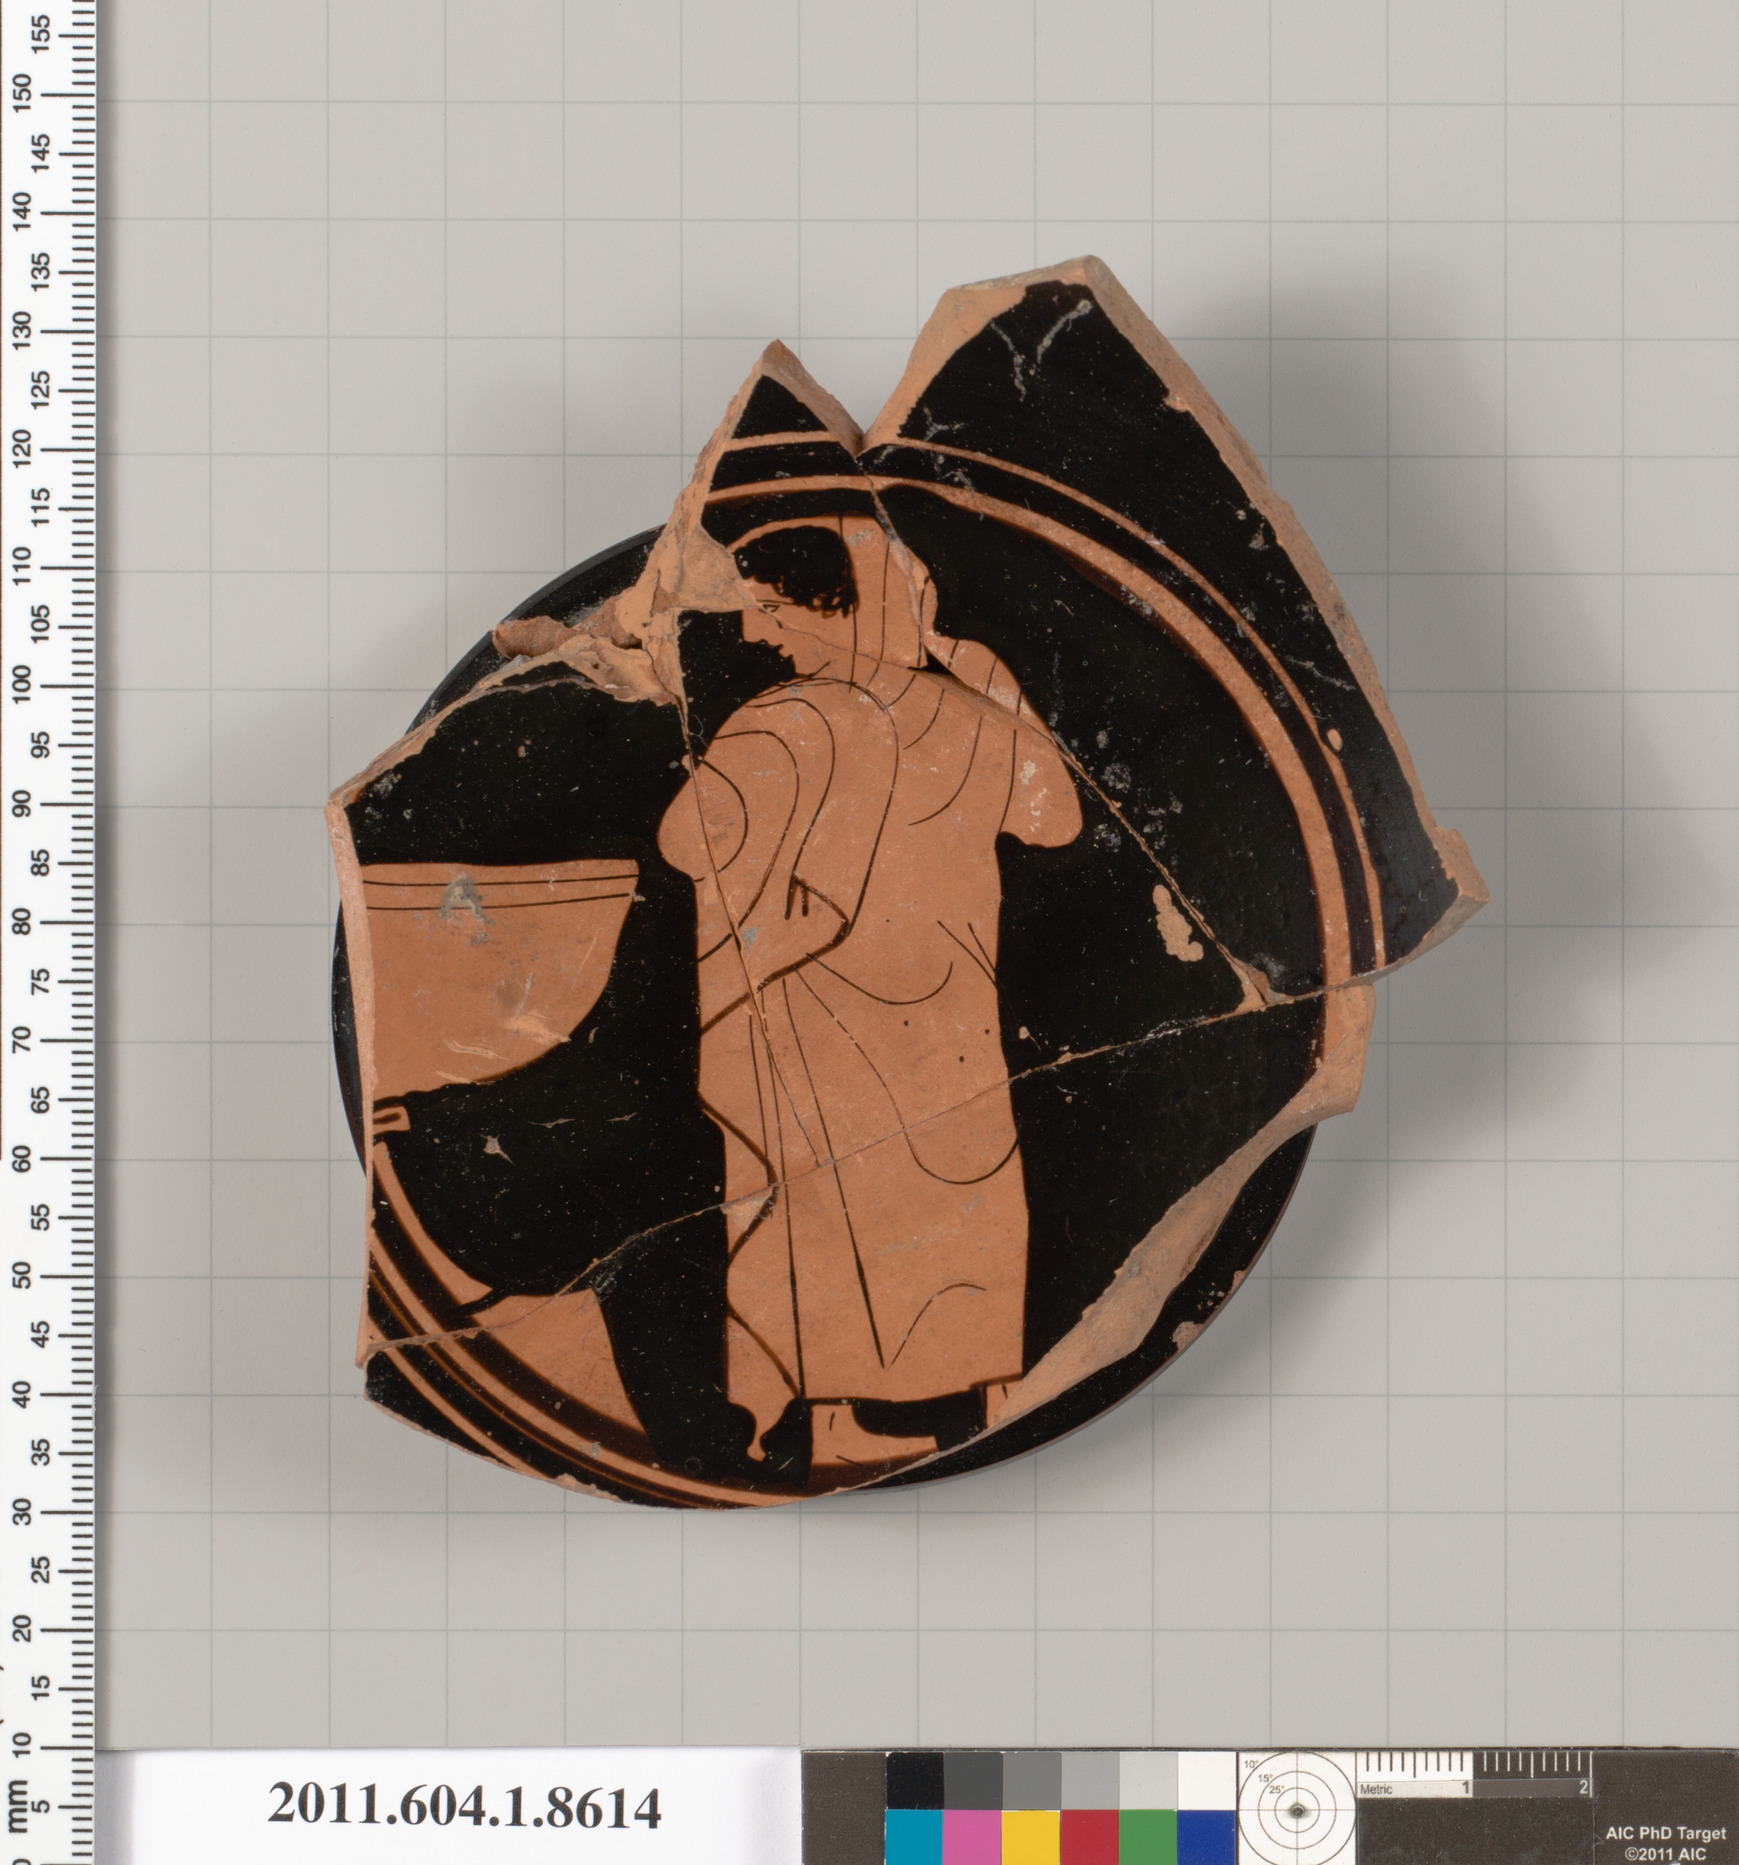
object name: kylix fragment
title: Terracotta fragment of a stemless kylix (drinking cup)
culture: greek, attic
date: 460-450 BCE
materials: terracotta